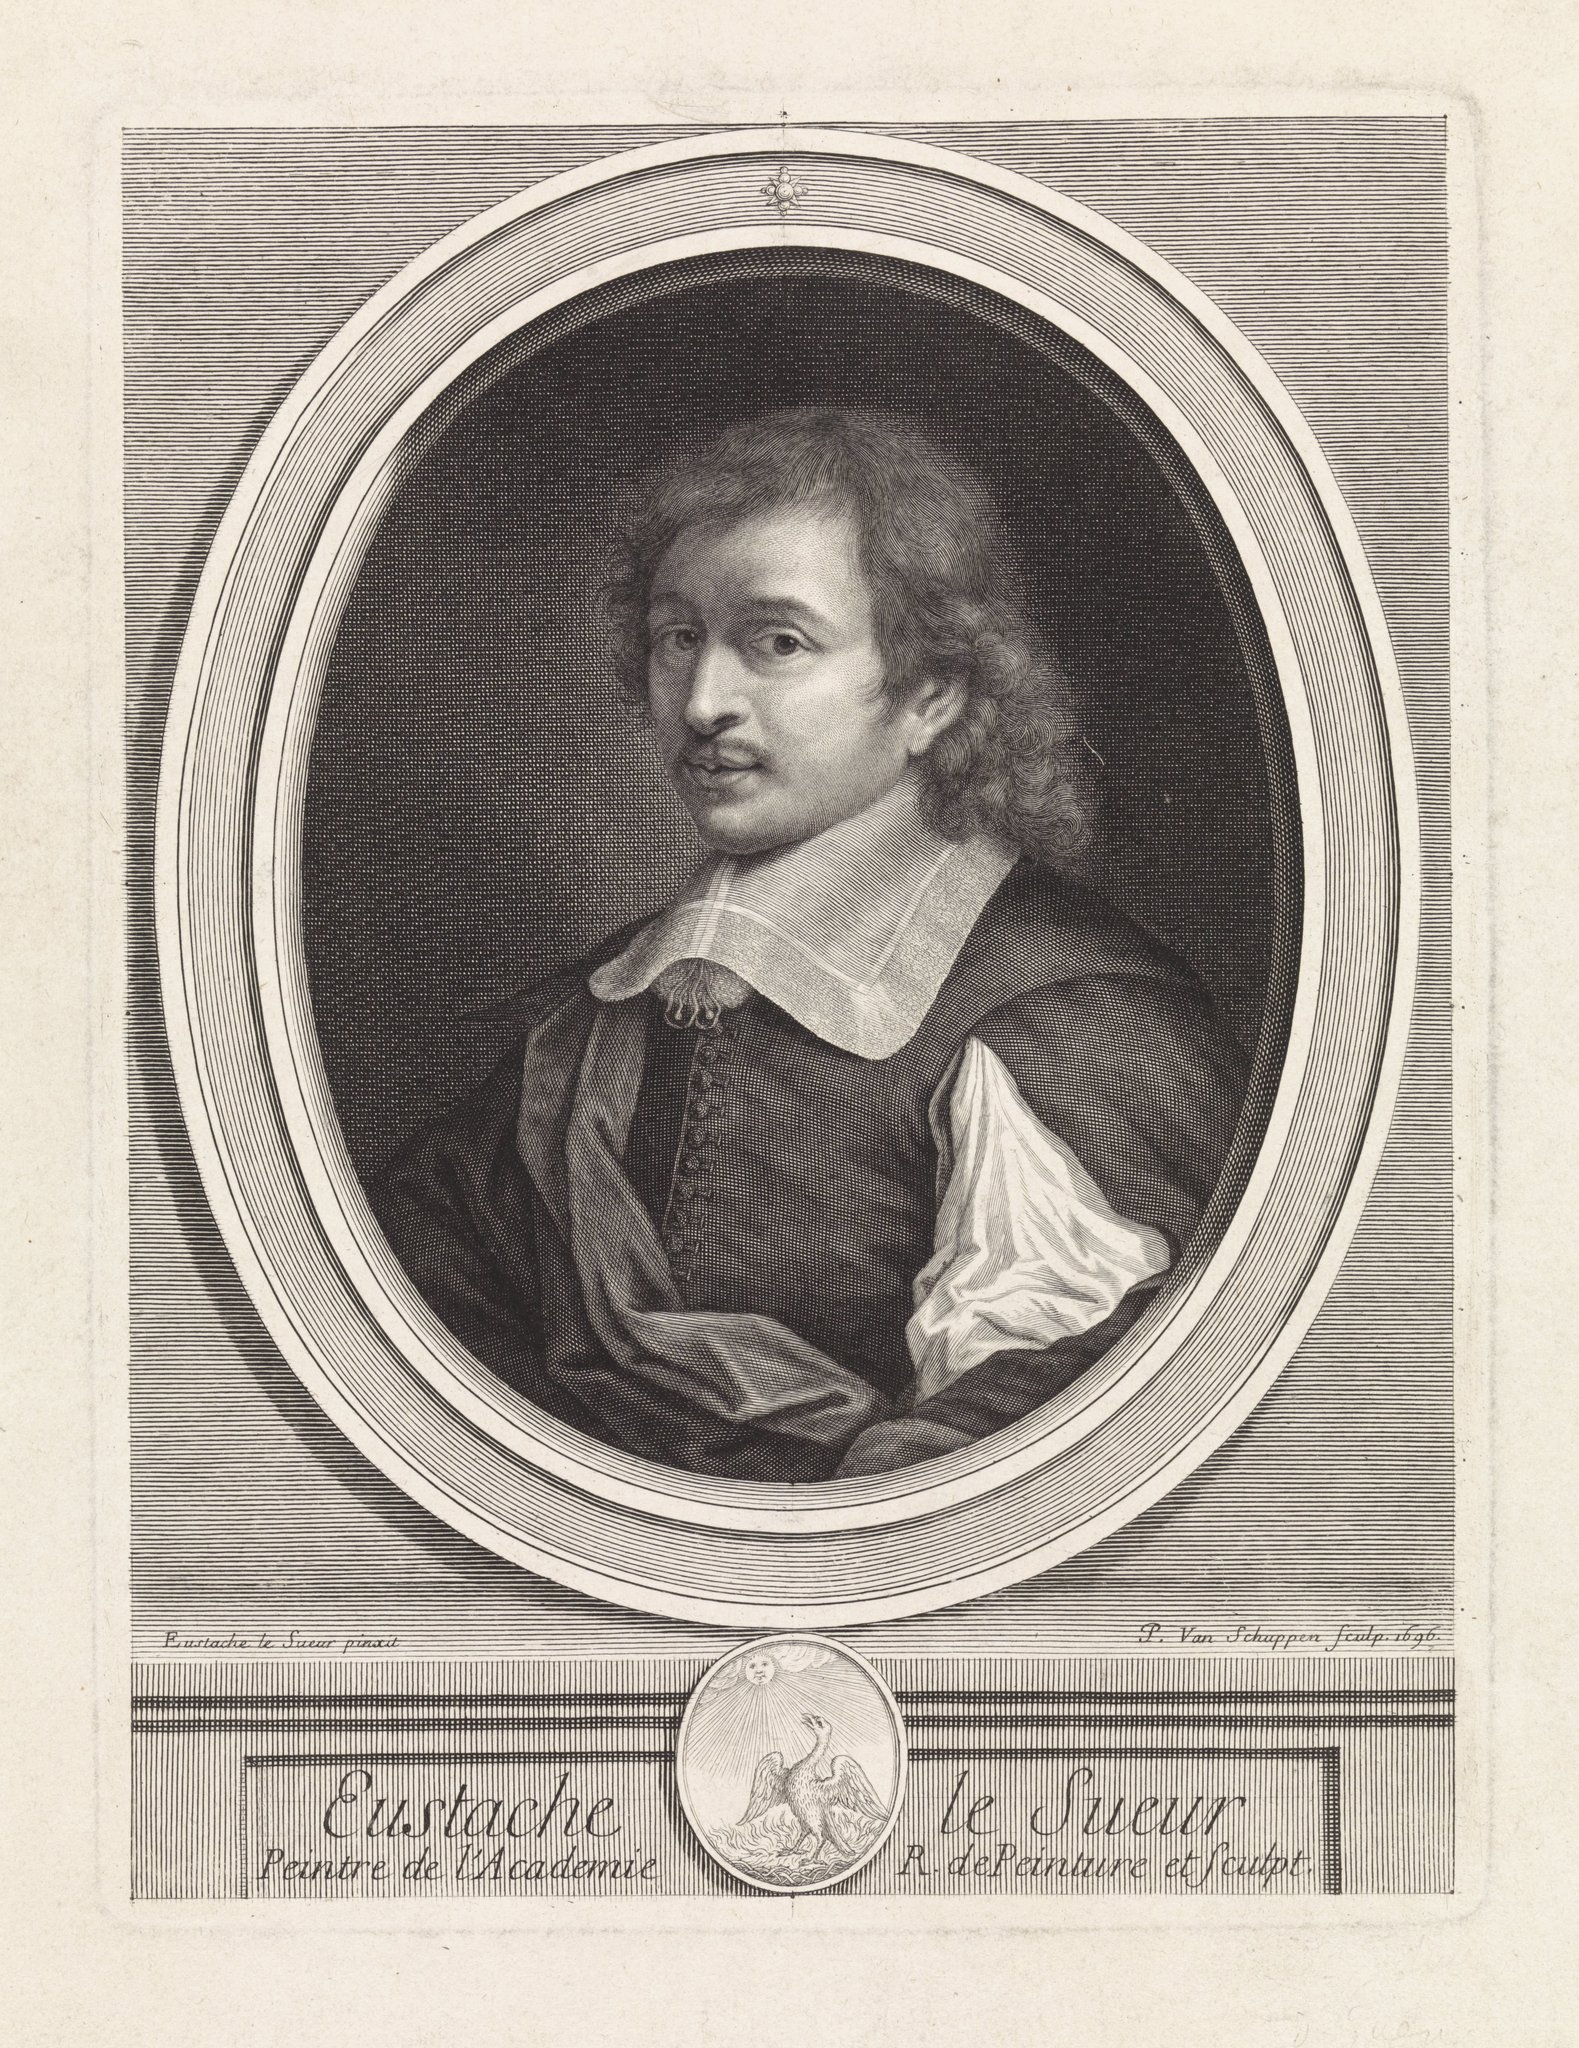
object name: print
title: Portret van de schilder Eustache Lesueur, naar zijn zelfportret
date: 1607-1696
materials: paper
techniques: engraving, etching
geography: paris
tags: paris, painter, draughtsman, eustache lesueur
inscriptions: collector's mark: Lugt 119, collector's mark: Lugt 2228